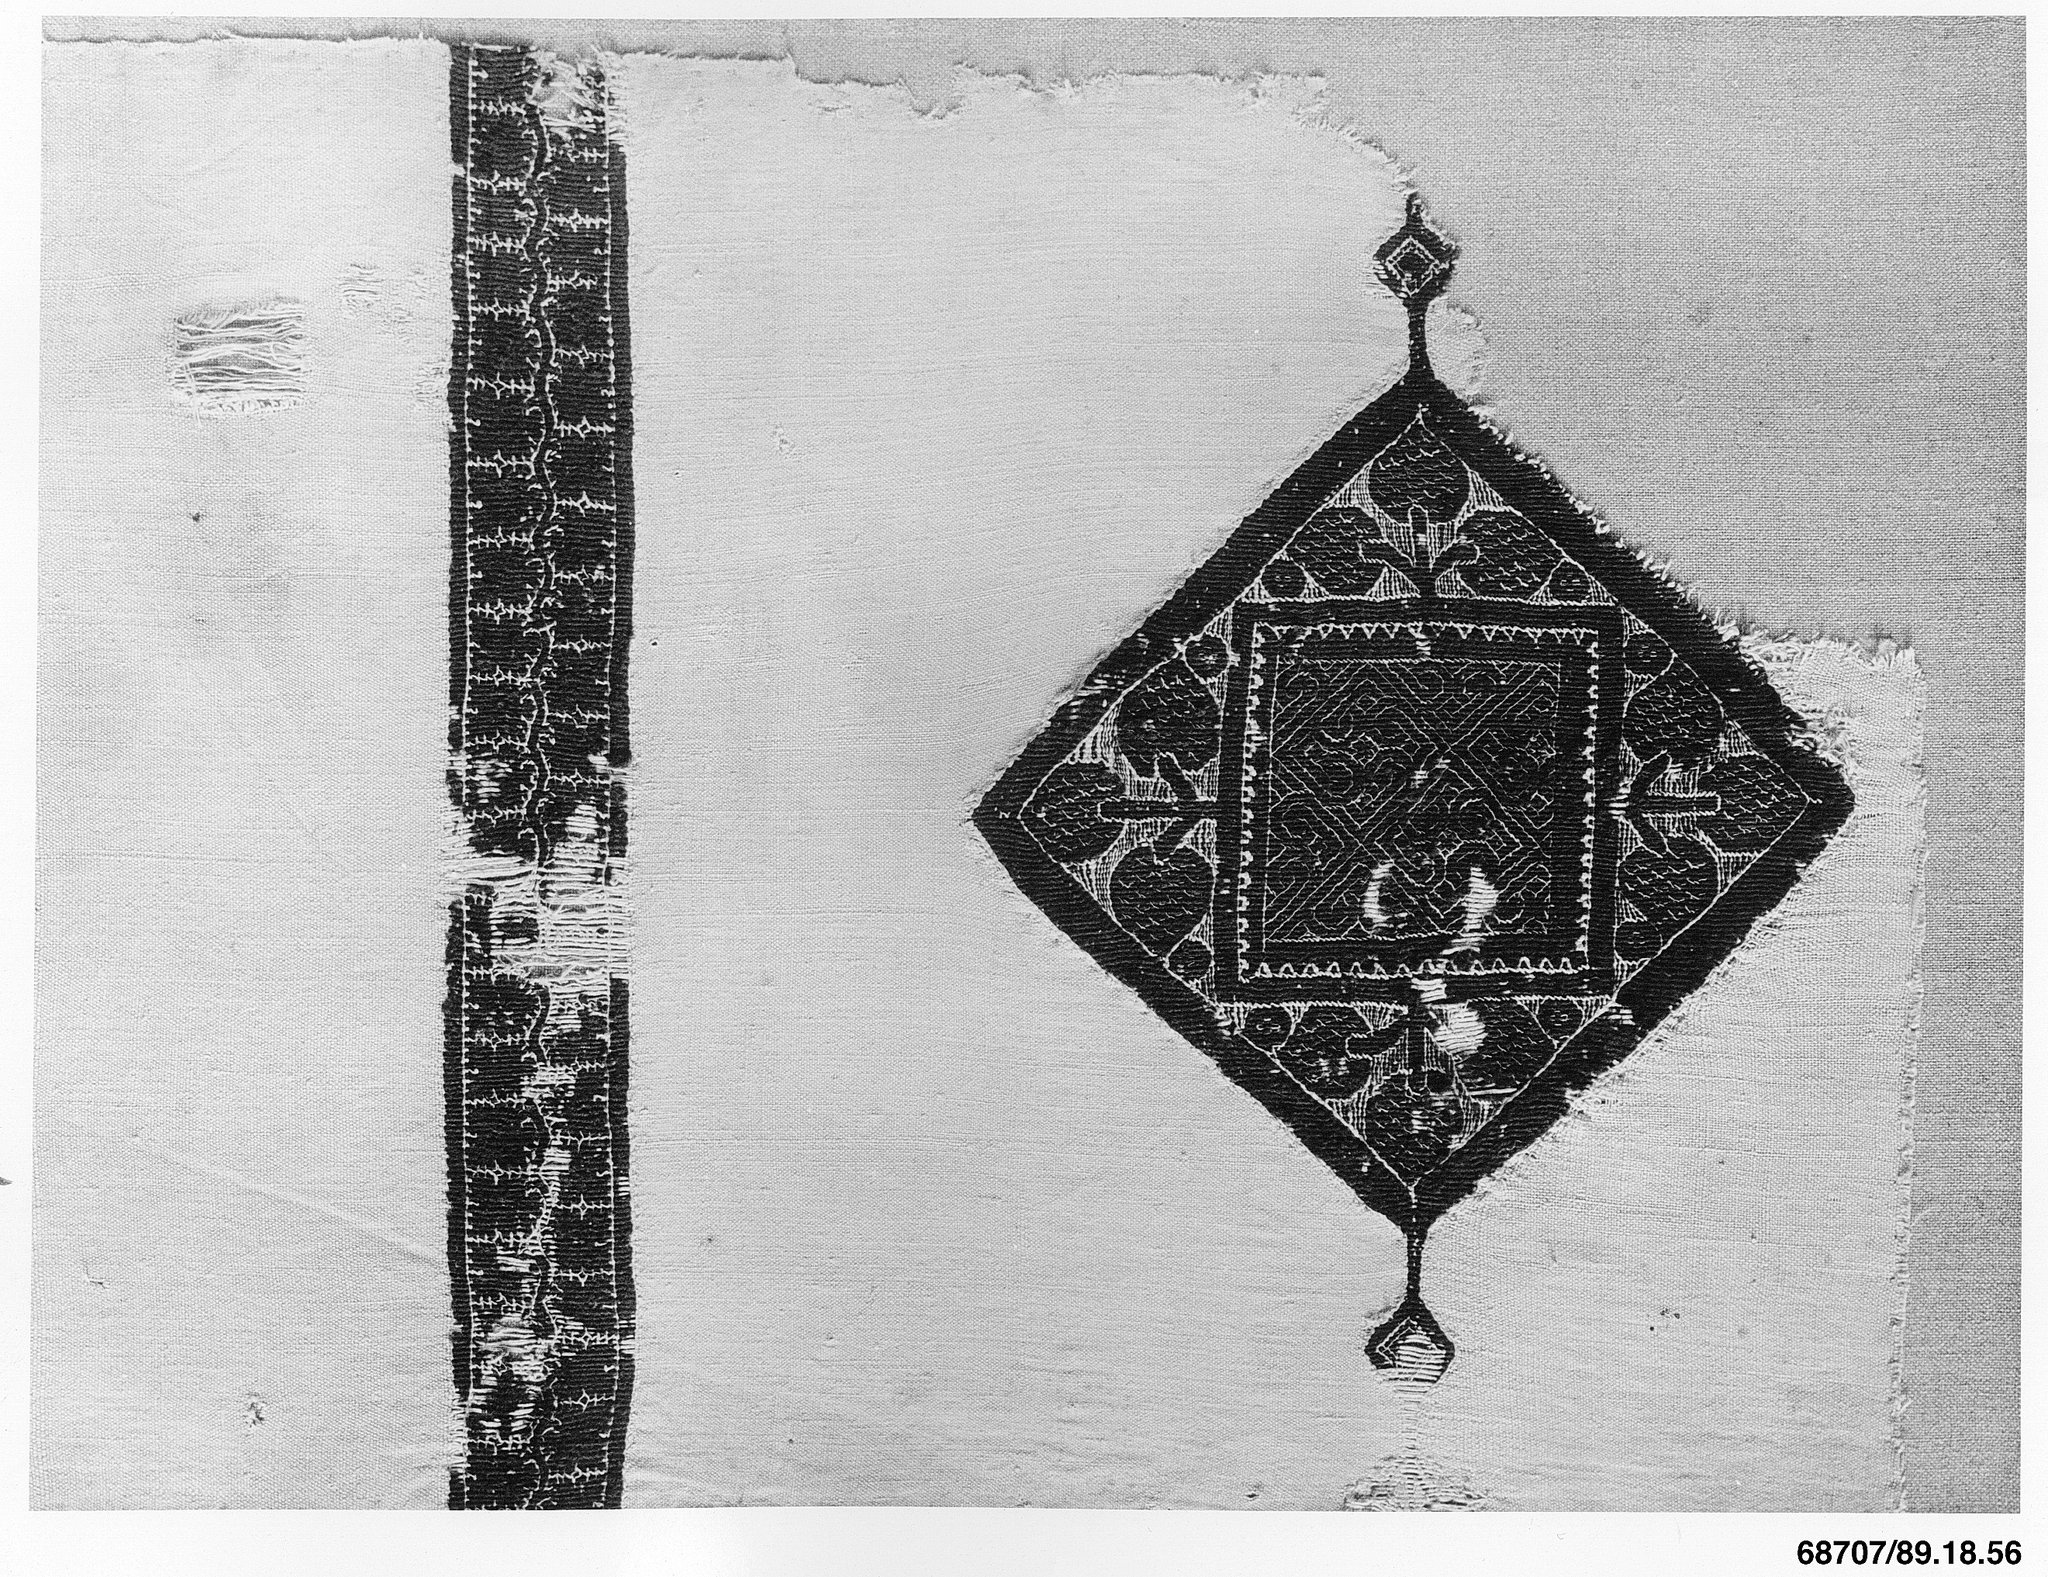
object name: textile fragment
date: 201-400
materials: linen, wool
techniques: weave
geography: egypt